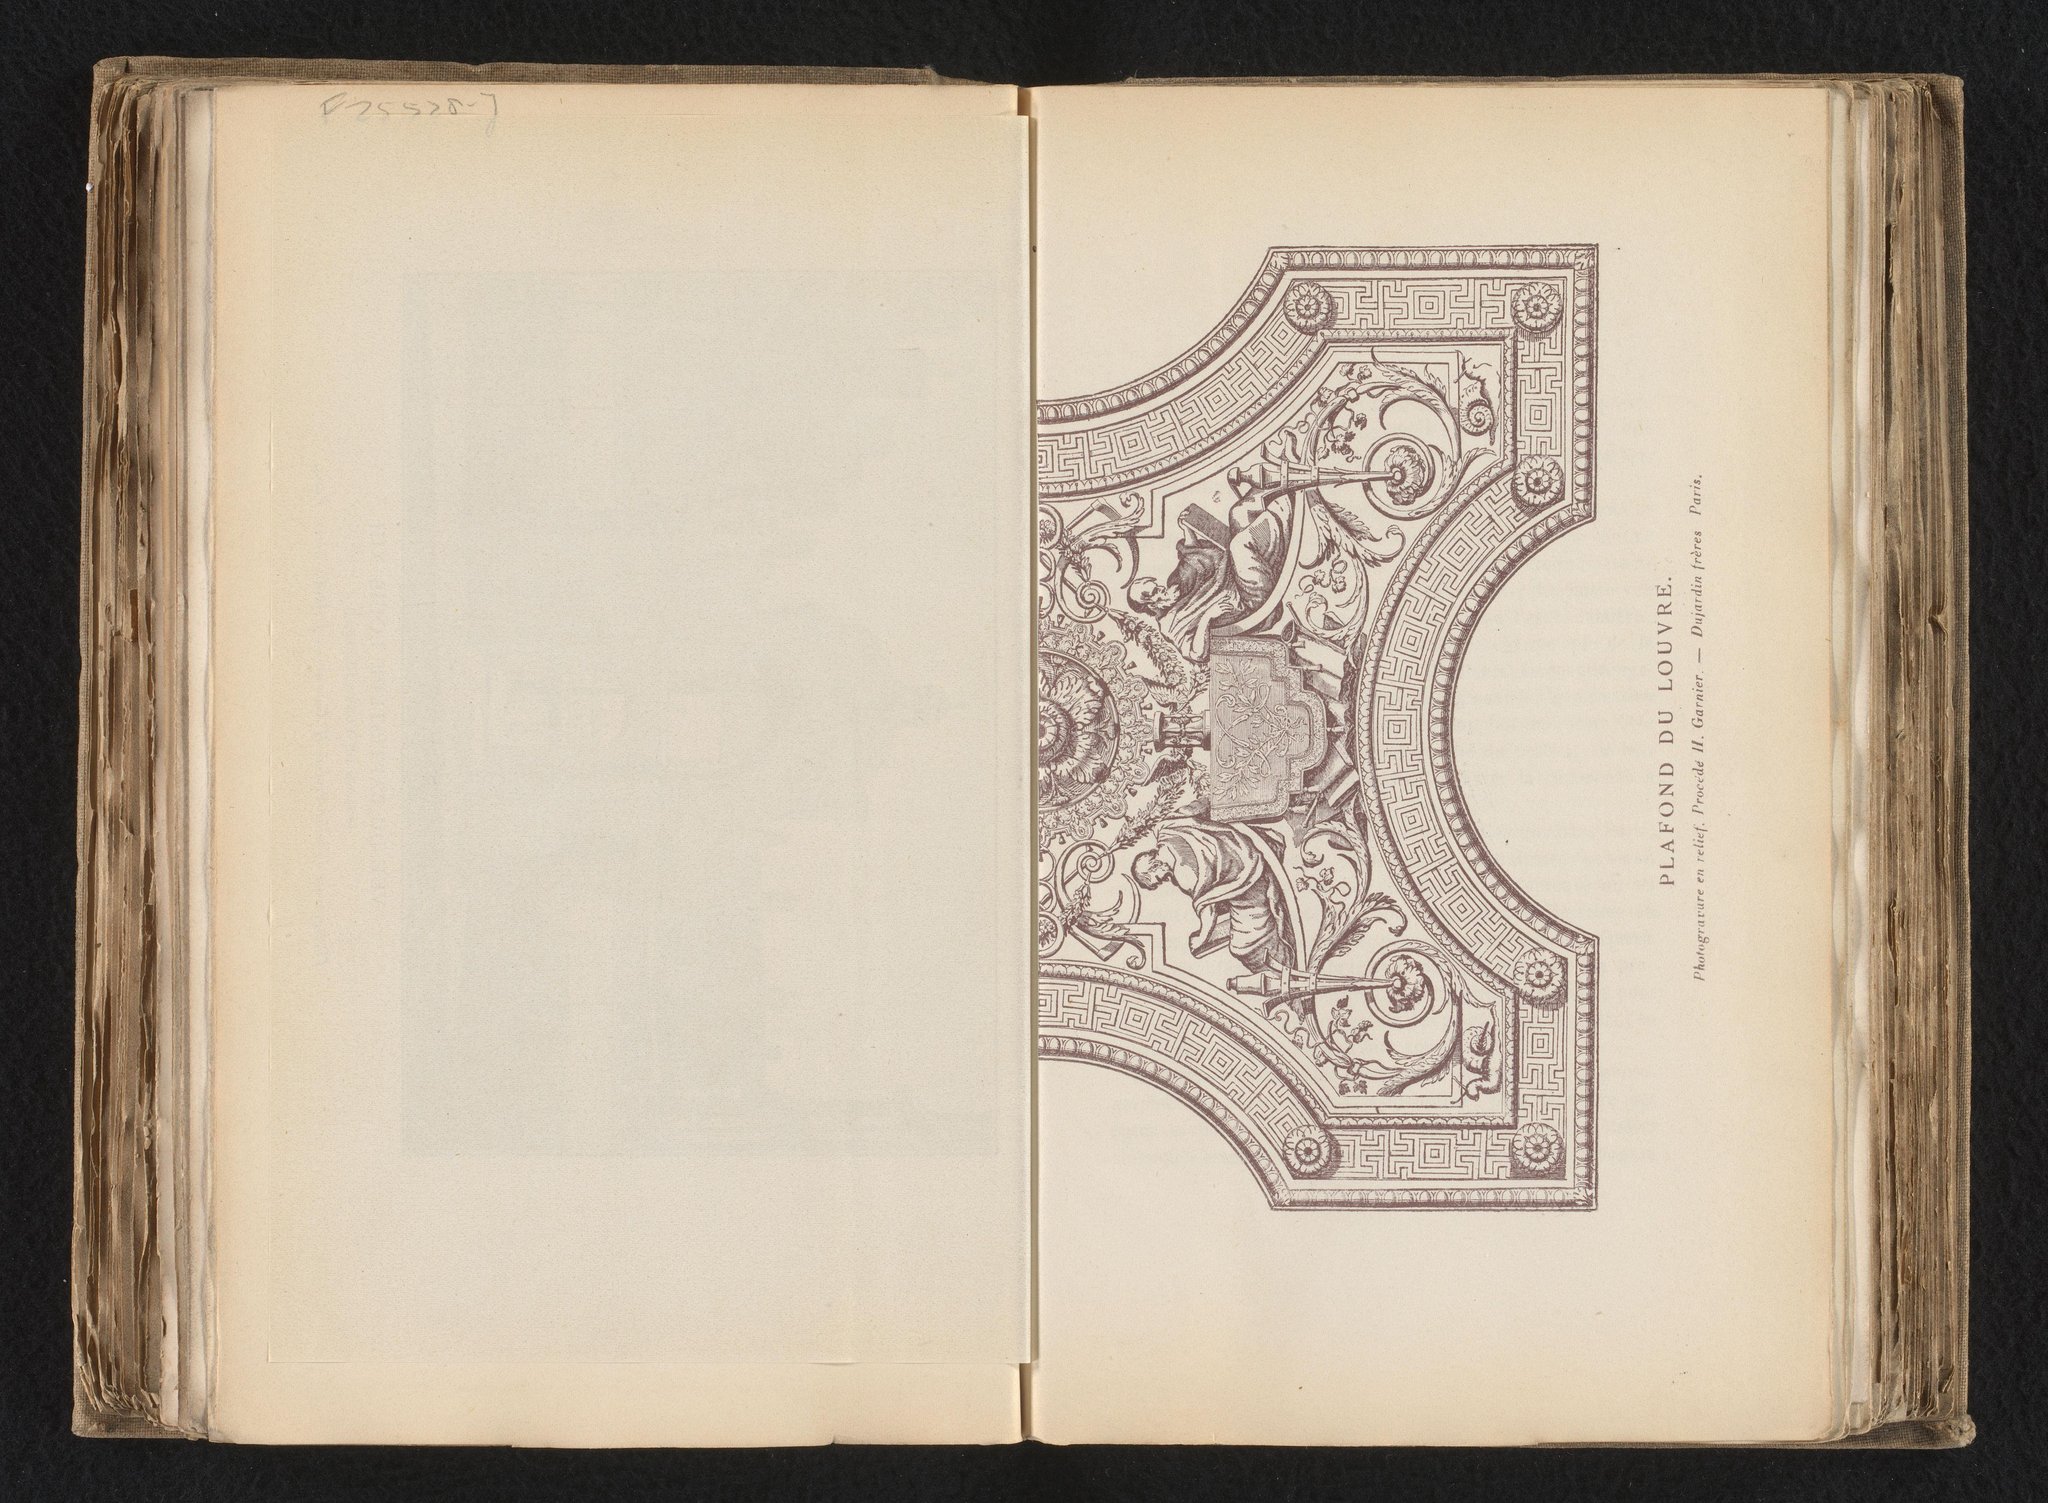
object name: photomechanical print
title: Reproductie van een gravure van een plafonddeel in het Louvre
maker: henry garnier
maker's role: printer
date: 1865-1870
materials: paper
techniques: photoaquatint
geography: paris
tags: (decorated) ceiling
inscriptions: inscription: ‘Photogravure en relief. Procédé II. garnier. - Dujardin frères Paris.’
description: Prent op derde ongenummerde pagina na pagina 204.